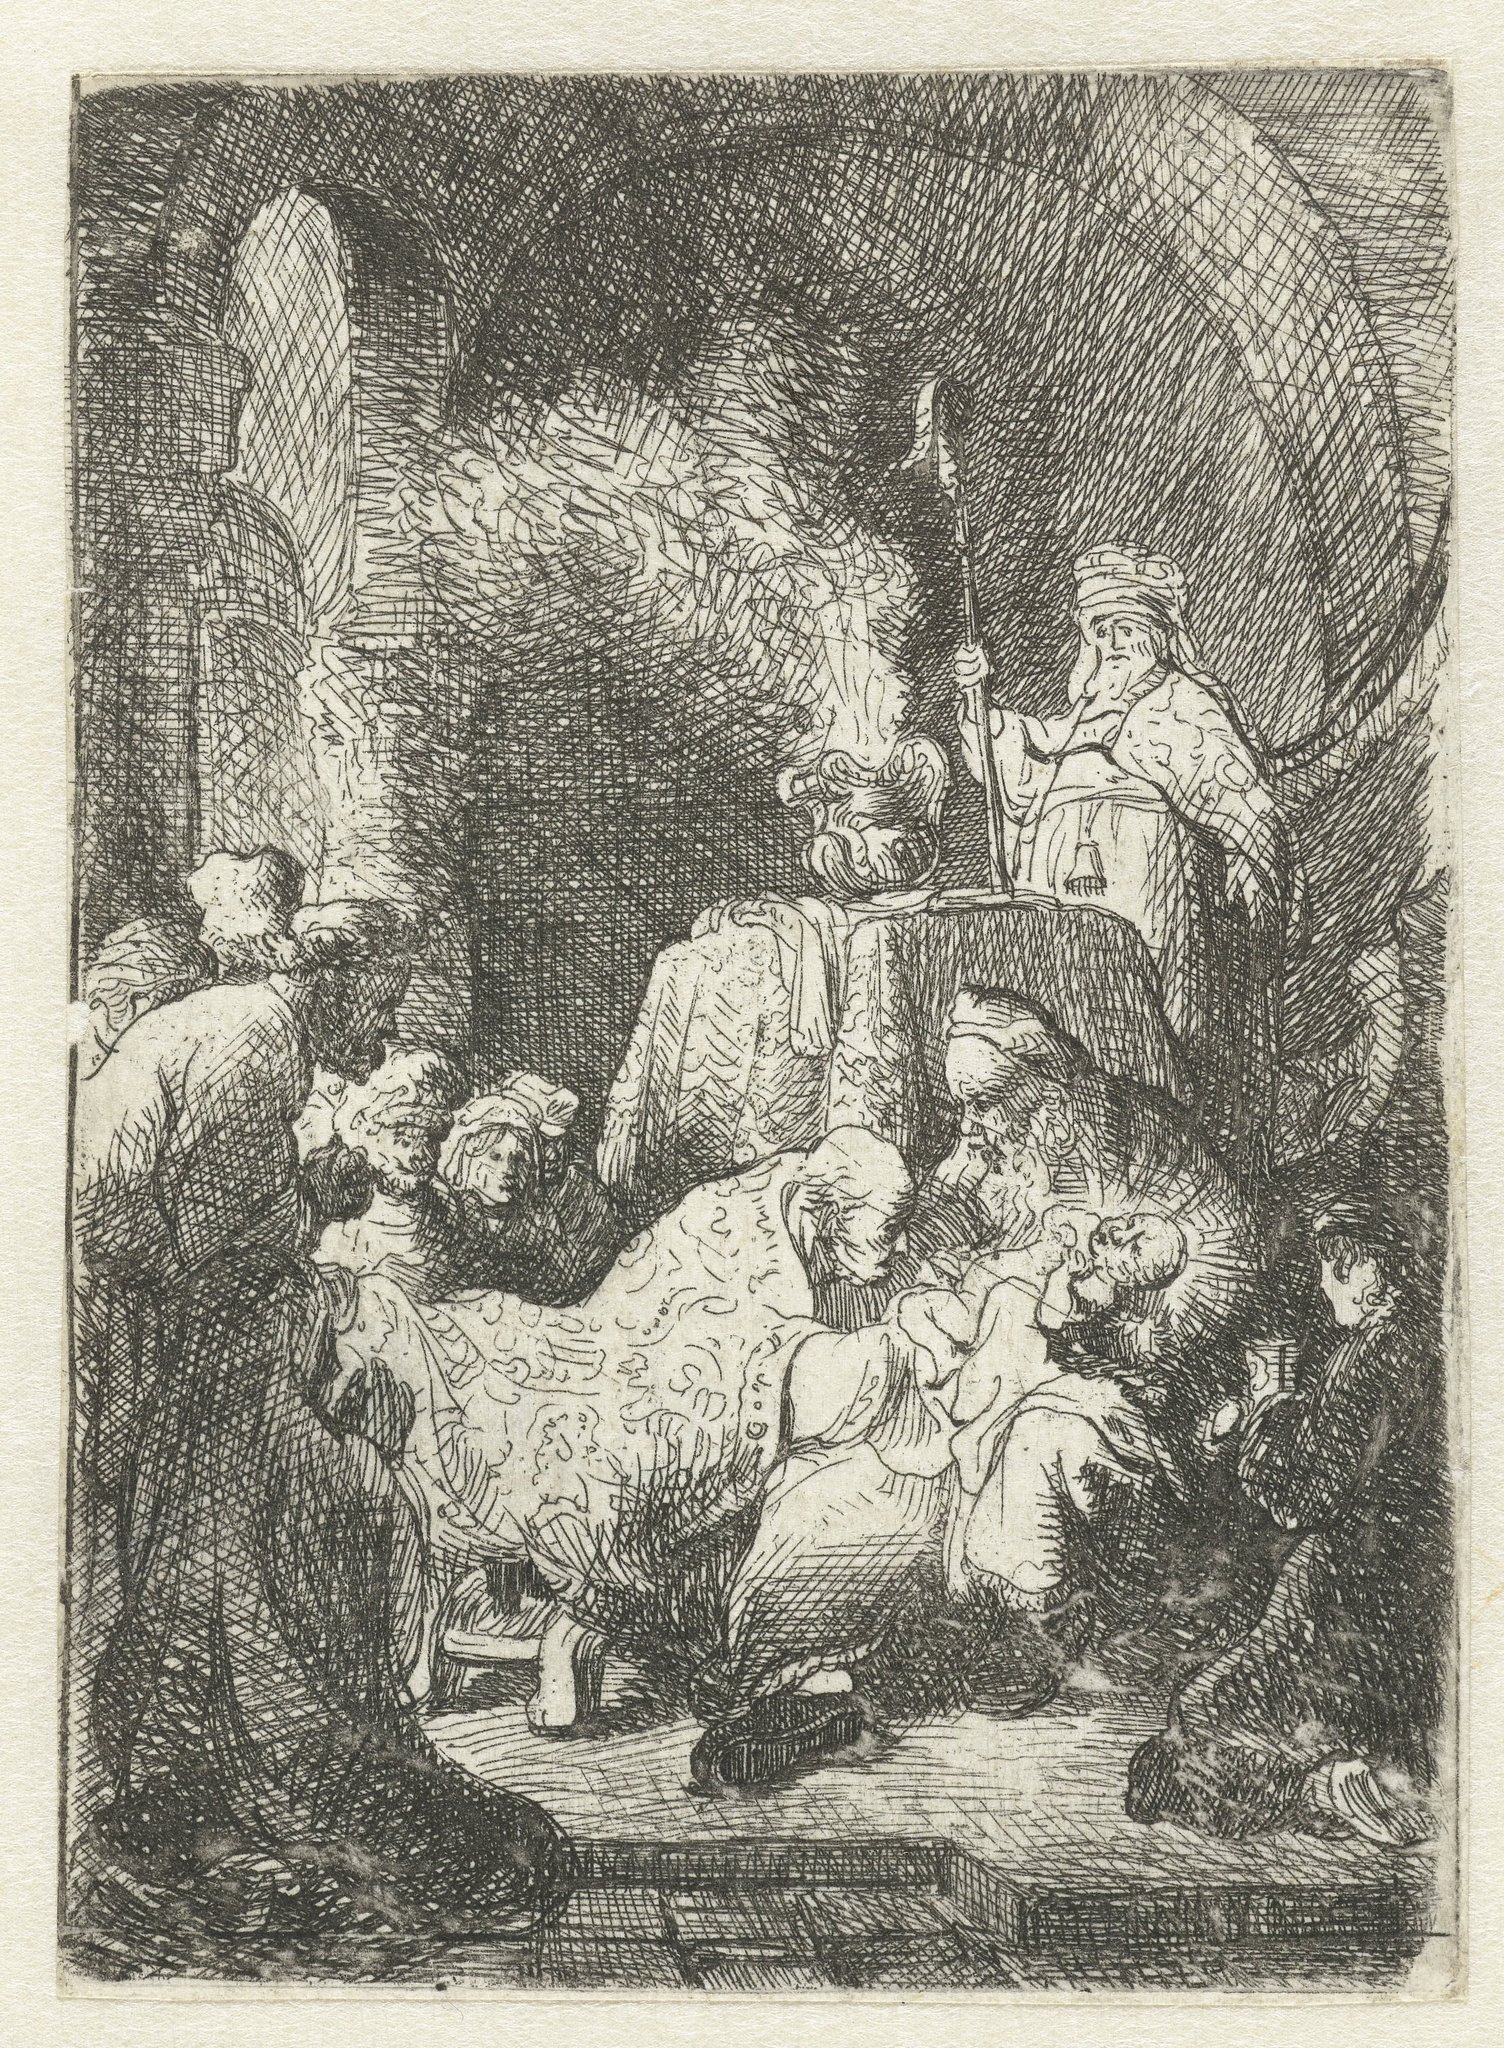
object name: print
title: The circumcision: small plate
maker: jan gillisz. van vliet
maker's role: draughtsman, painter, print maker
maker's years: 1600-1668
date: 1620-1668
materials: paper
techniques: etching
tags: story of noah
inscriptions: collector's mark: Lugt 240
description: Spiegelbeeldige kopie naar de gelijknamige prent van Rembrandt.